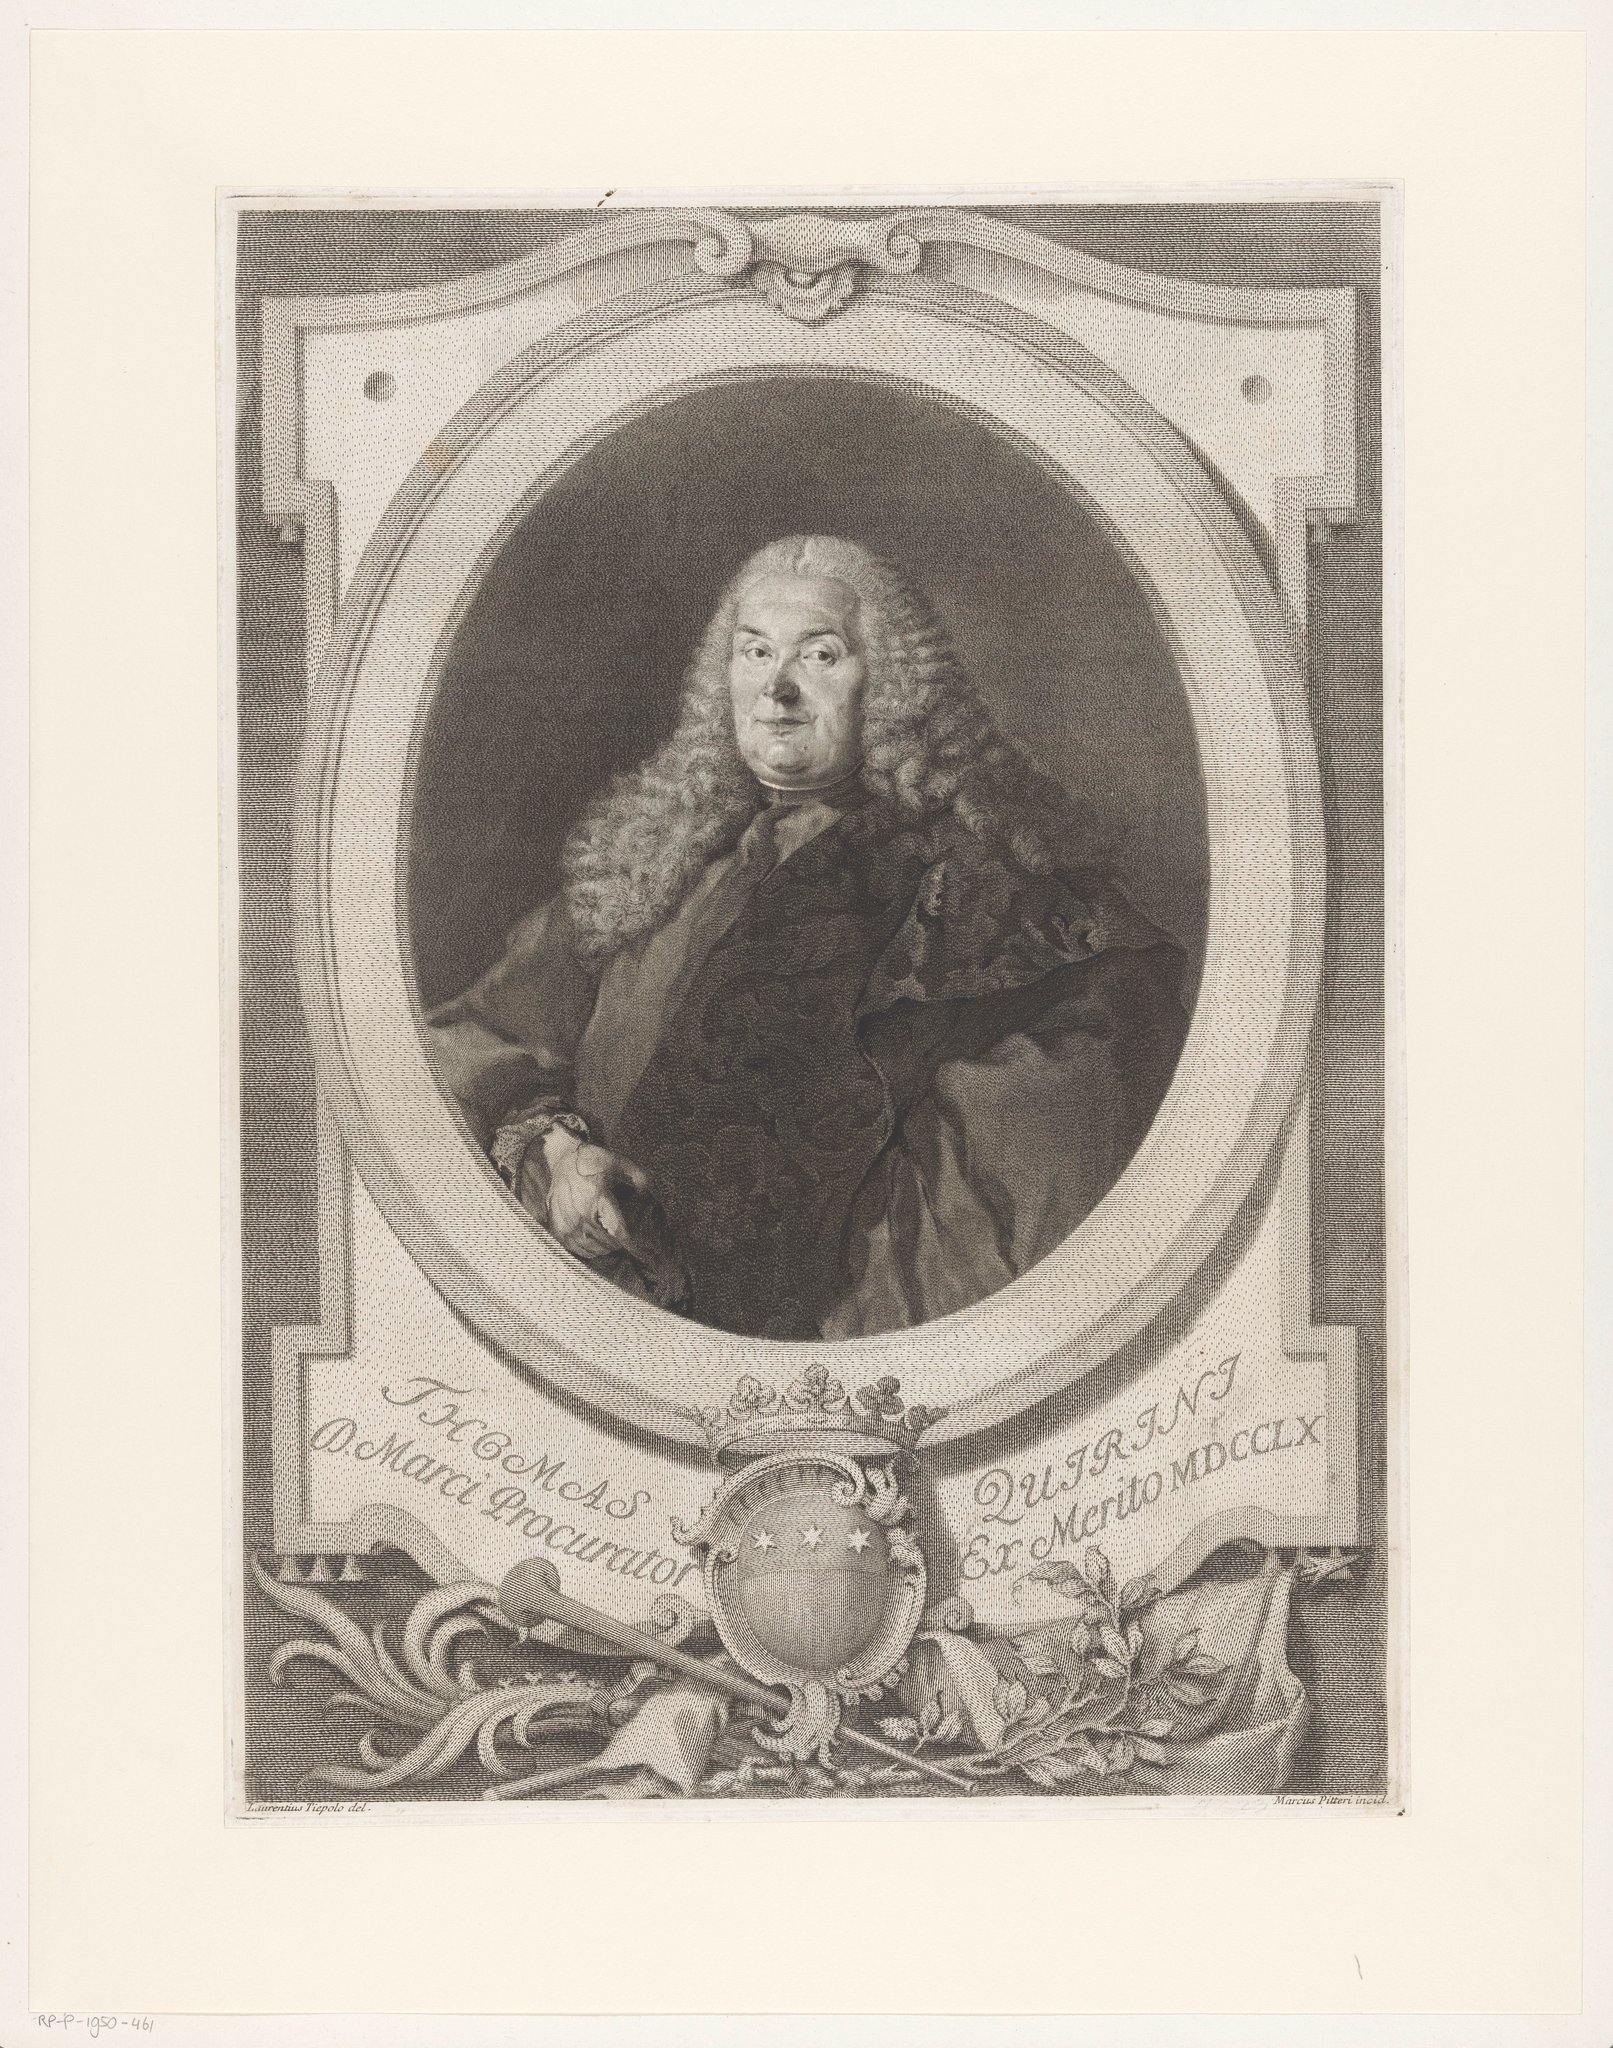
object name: print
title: Portret van Tommaso Querini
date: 1760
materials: paper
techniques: engraving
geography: venice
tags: historical persons, ruler, sovereign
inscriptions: collector's mark: Lugt 2228